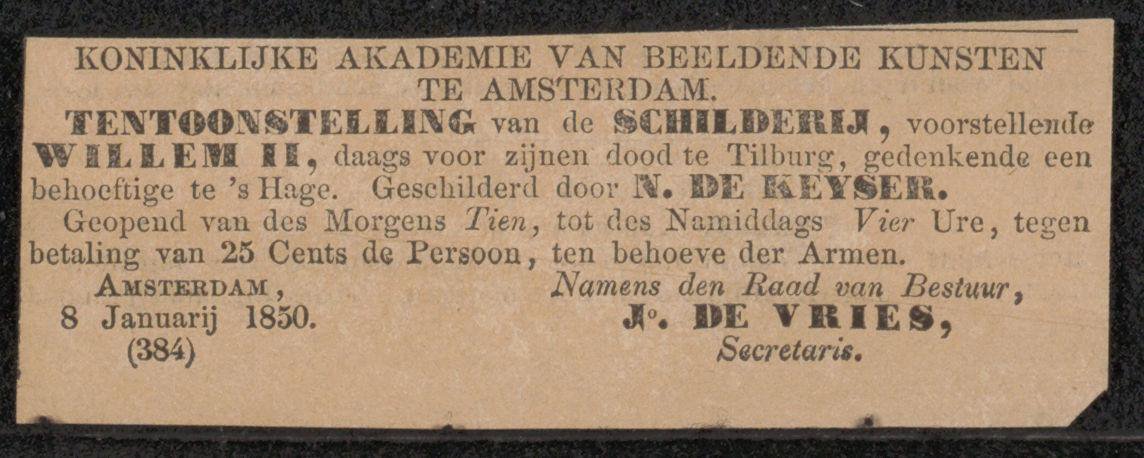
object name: newspaper clipping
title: Krantenknipsel betreffende Nicaise De Keyser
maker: jeronimo de vries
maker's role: secretaris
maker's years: 1776-1853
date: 1850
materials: paper, ink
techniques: printing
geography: amsterdam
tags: antwerp, painter, draughtsman, nicaise de keyser, the hague, william ii of the netherlands, painting (including book-illumination, miniature-painting), exhibition ~ art, historical persons (portraits and scenes from the life)